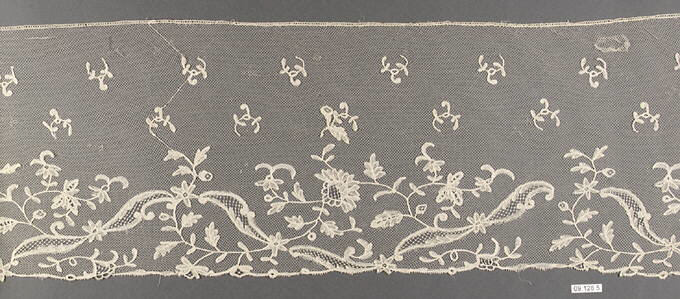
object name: flounce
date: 1801-1900